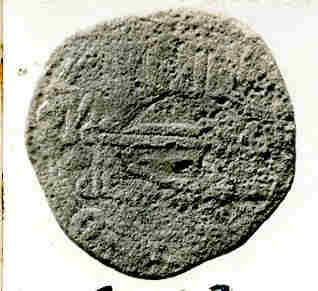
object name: coin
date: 718-814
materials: copper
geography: iran